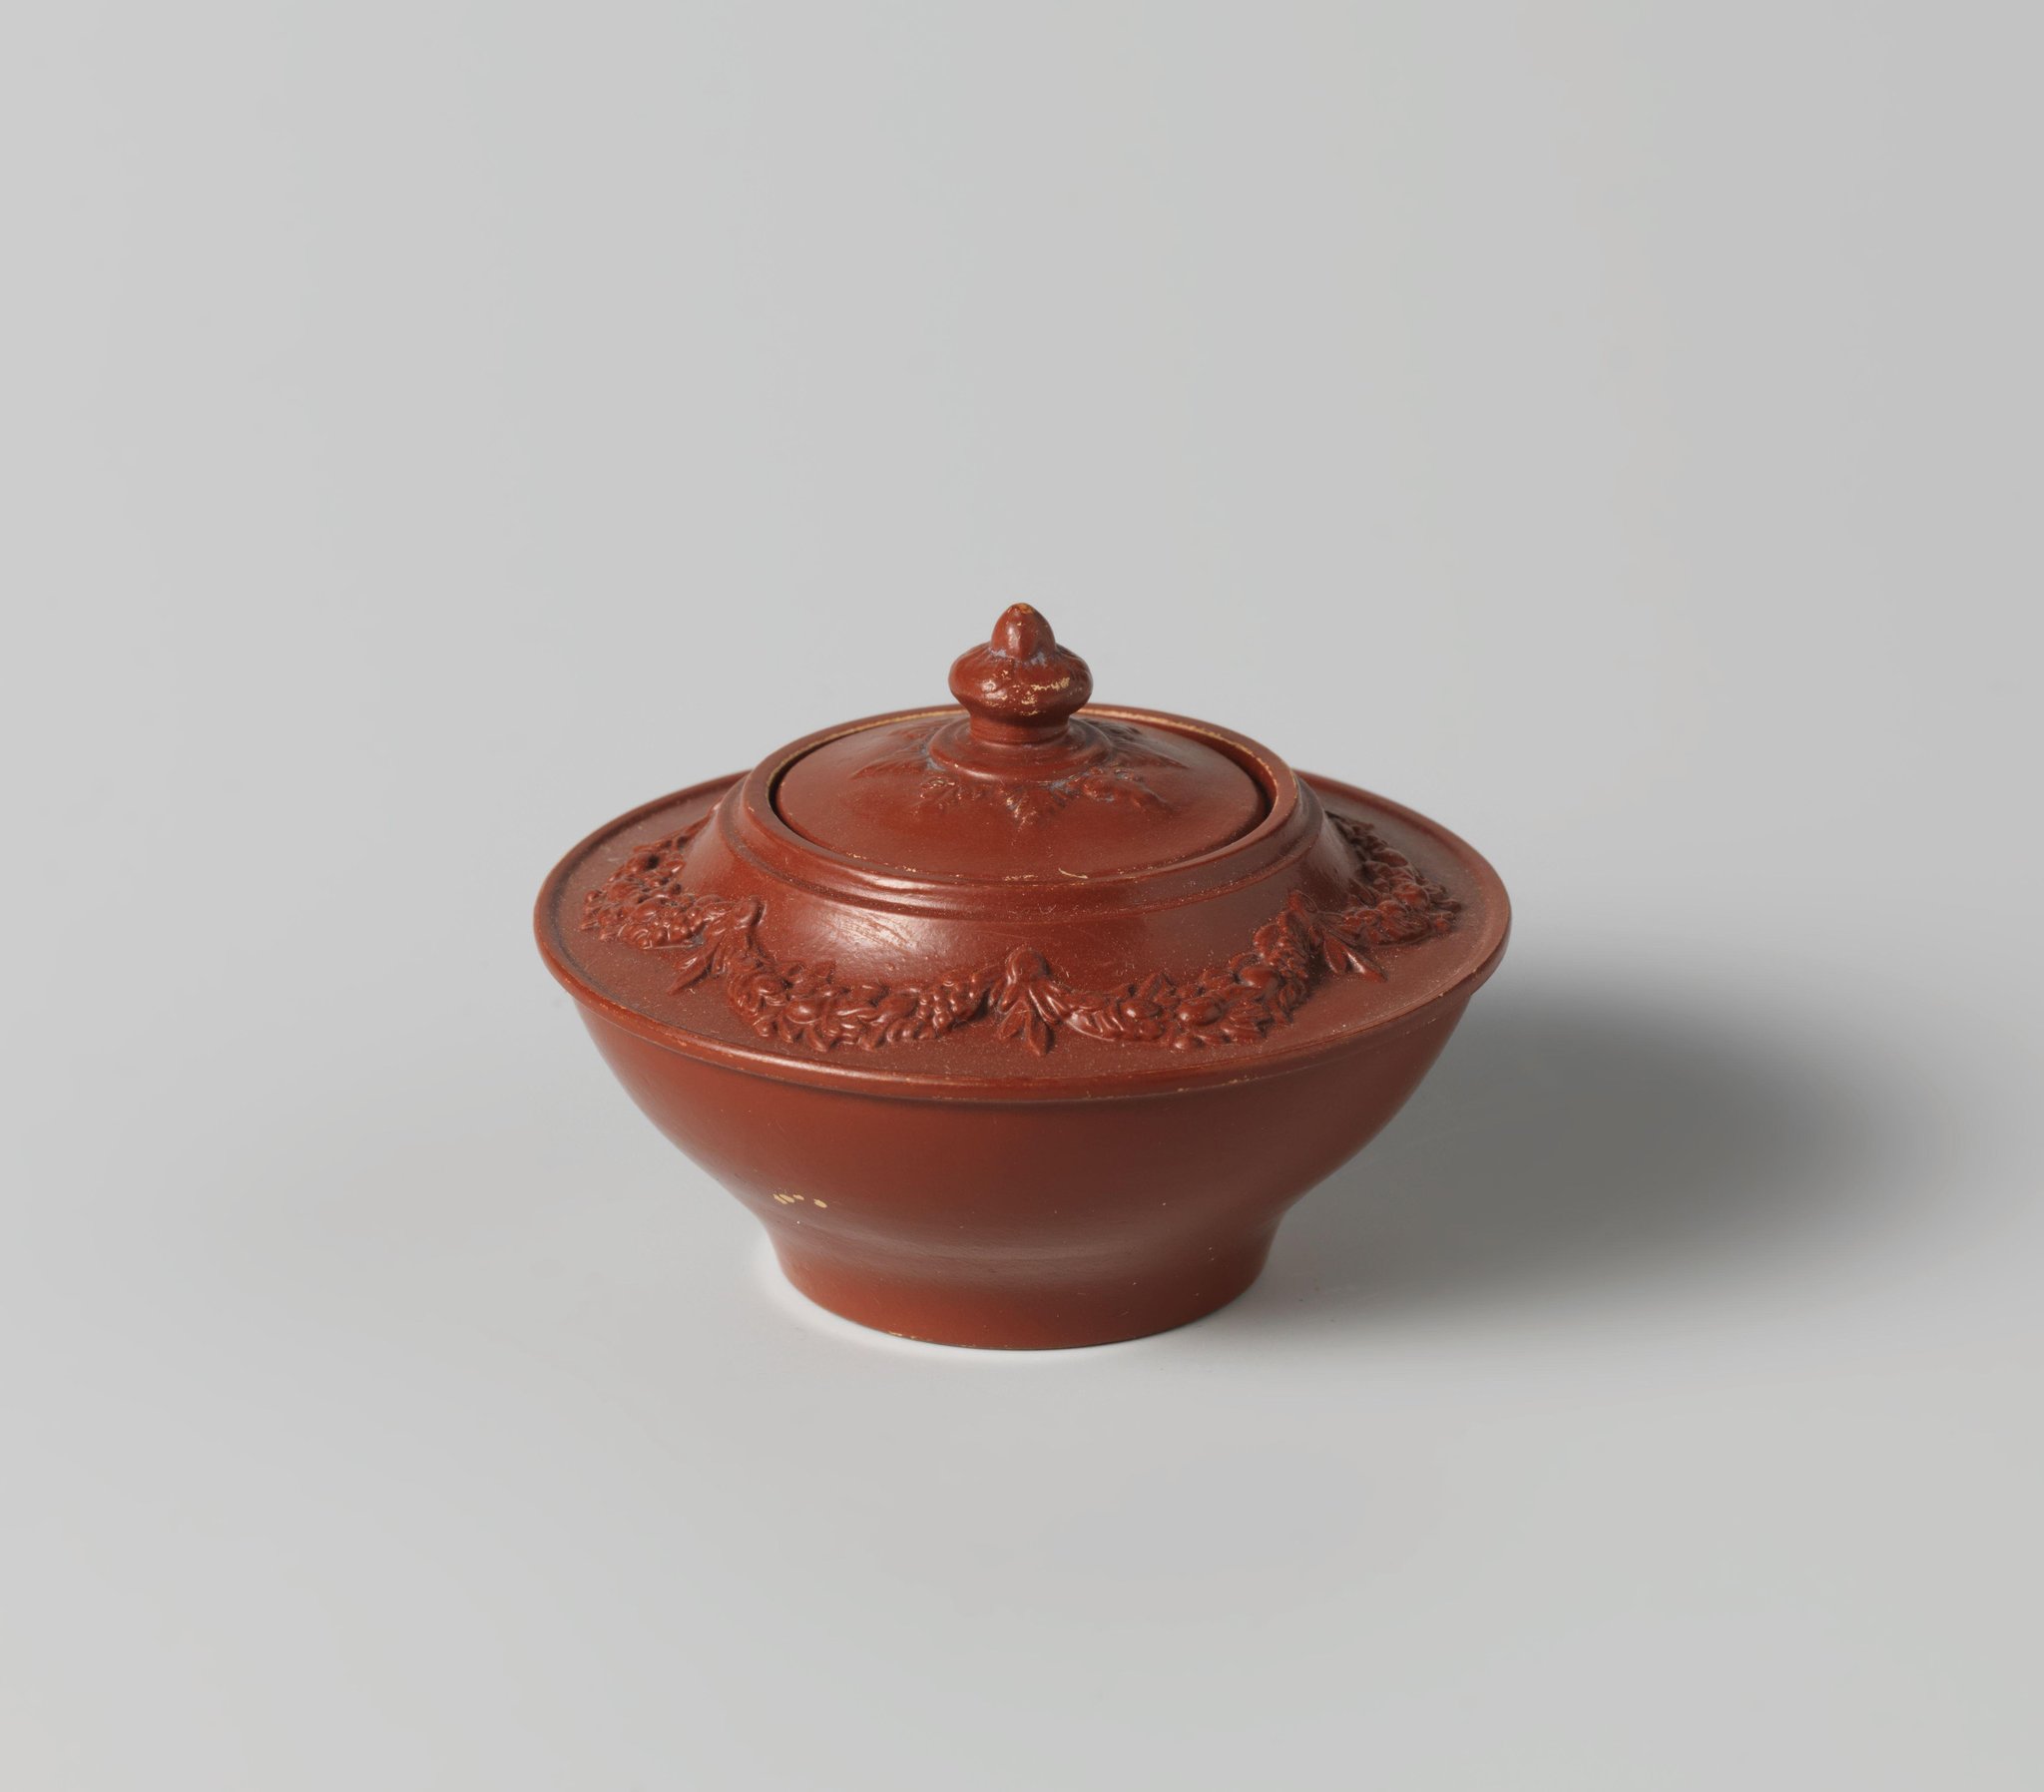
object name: sugar box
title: Suikerpot van rood hardgebakken aardewerk, kinderspeelgoed.Met deksel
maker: Anonymous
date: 1830-1860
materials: earthenware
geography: bohemia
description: Halfbolvormige suikerpot van rode, hardgebakken aardewerk. De pot heeft een standring en een gewelfd deksel met een vrucht als knop. De suikerpot is in reliëf vesierd met guirlandes van bladeren en vruchten. De suikerpot hoort bij een miniatuur theeservies (BK-15429-A t/m BK-15429-D). Bij de suikerpot hoort een deksel.